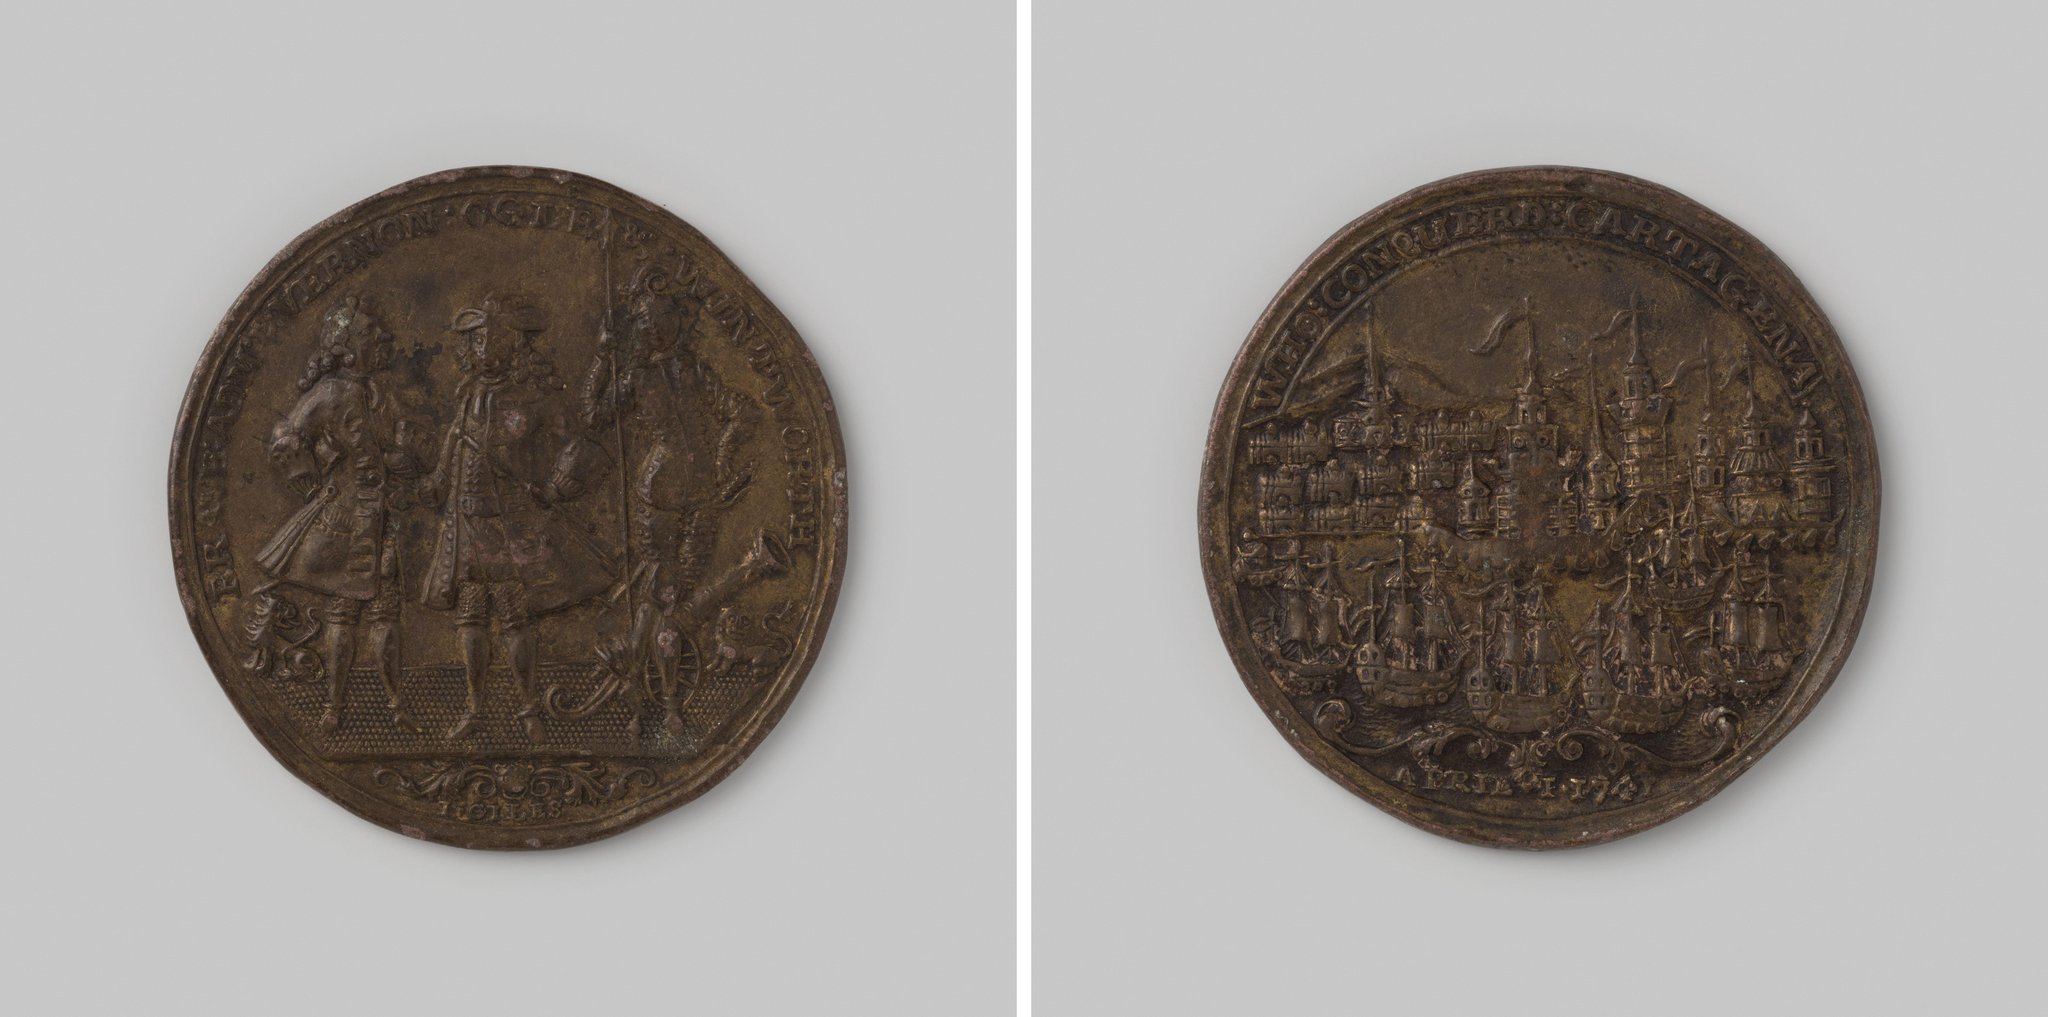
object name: history medal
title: Inname van Carthagena door Vernon, Ogle en Wentworth 1741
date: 1741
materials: brass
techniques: striking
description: Messing penning, op de voorzijde Vernon, Ogle en Wentworth staand, aan hun voeten een kanon en twee leeuwen, met omschrift, op de keerzijde de vloot voor de haven van Cartagena met zijn kastelen, met omschrift en afsnedetekst.